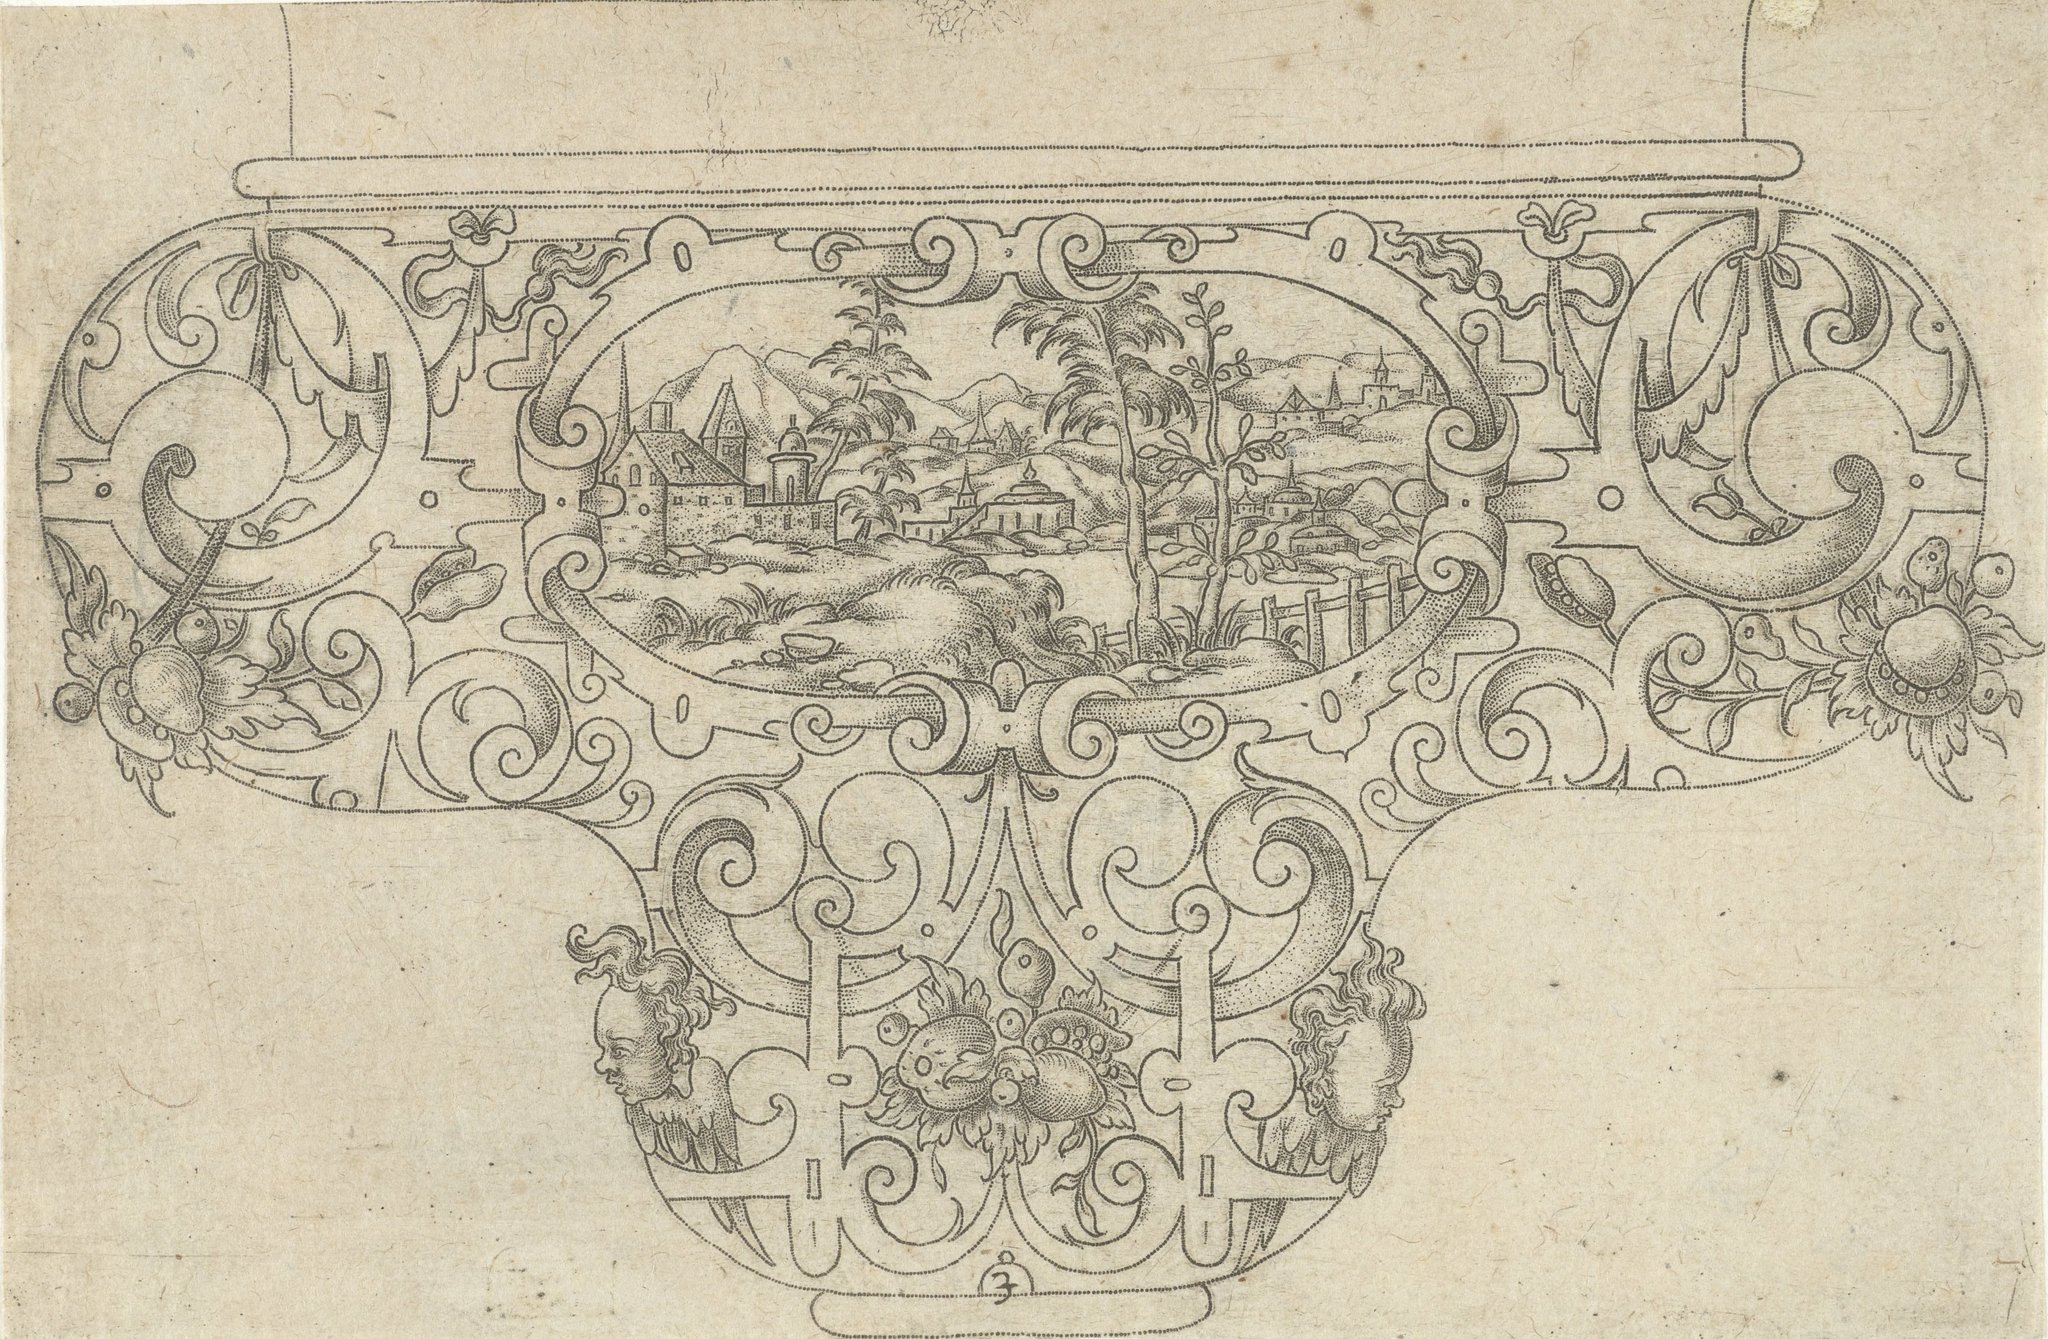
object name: ornament print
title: Bekers, bokalen en schalen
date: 1594-1635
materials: paper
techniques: engraving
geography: northern netherlands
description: Onderaan hangt een tros vruchten tussen twee cherubijntjes. Tegenzijdige kopieën van de onder Orn Cat I-324.A vermelde serie. Titelblad en 14 deels genummerde bladen uit een serie van 25.